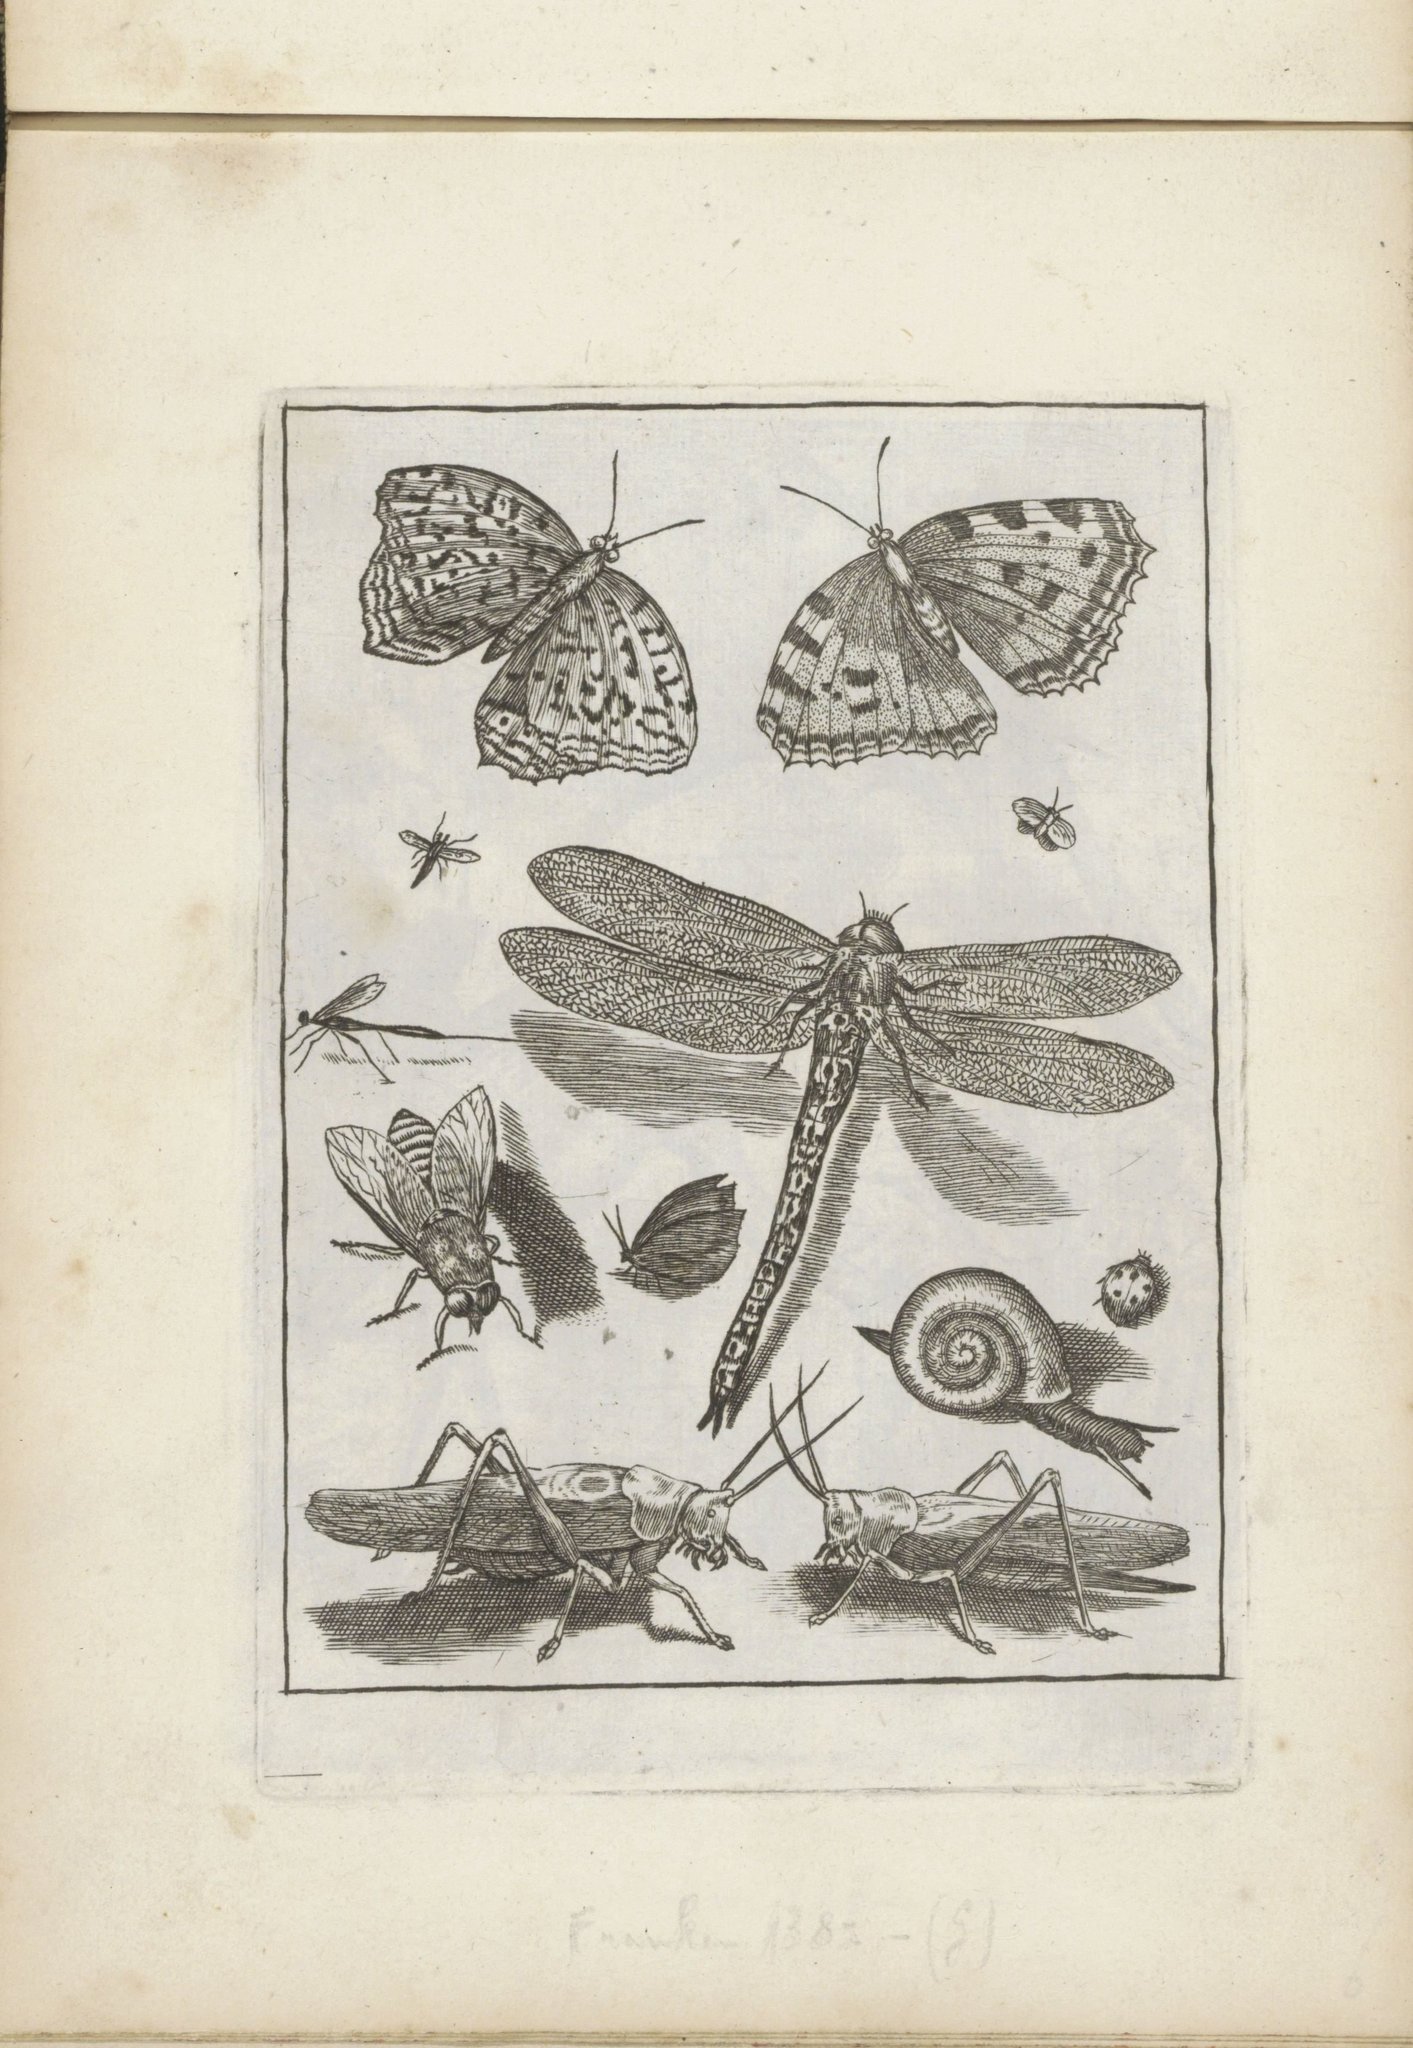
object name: print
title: Insecten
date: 1635-1660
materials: paper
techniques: engraving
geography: utrecht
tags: insects: butterfly, insects: grass-hopper, insects: fly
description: Verschillende insecten: onder andere vlinders, libelle, bromvlieg, lieveheersbeest, slak en sprinkhanen. Deze prent maakt deel uit van een album.